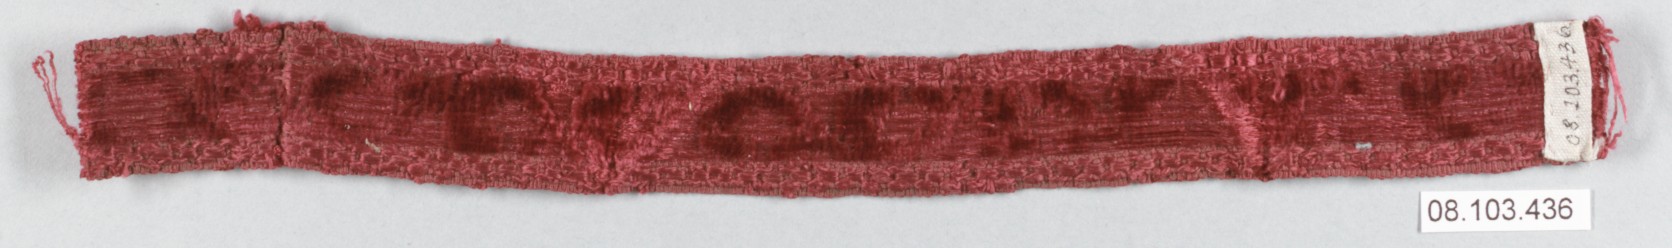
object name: galloon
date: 1701-1800